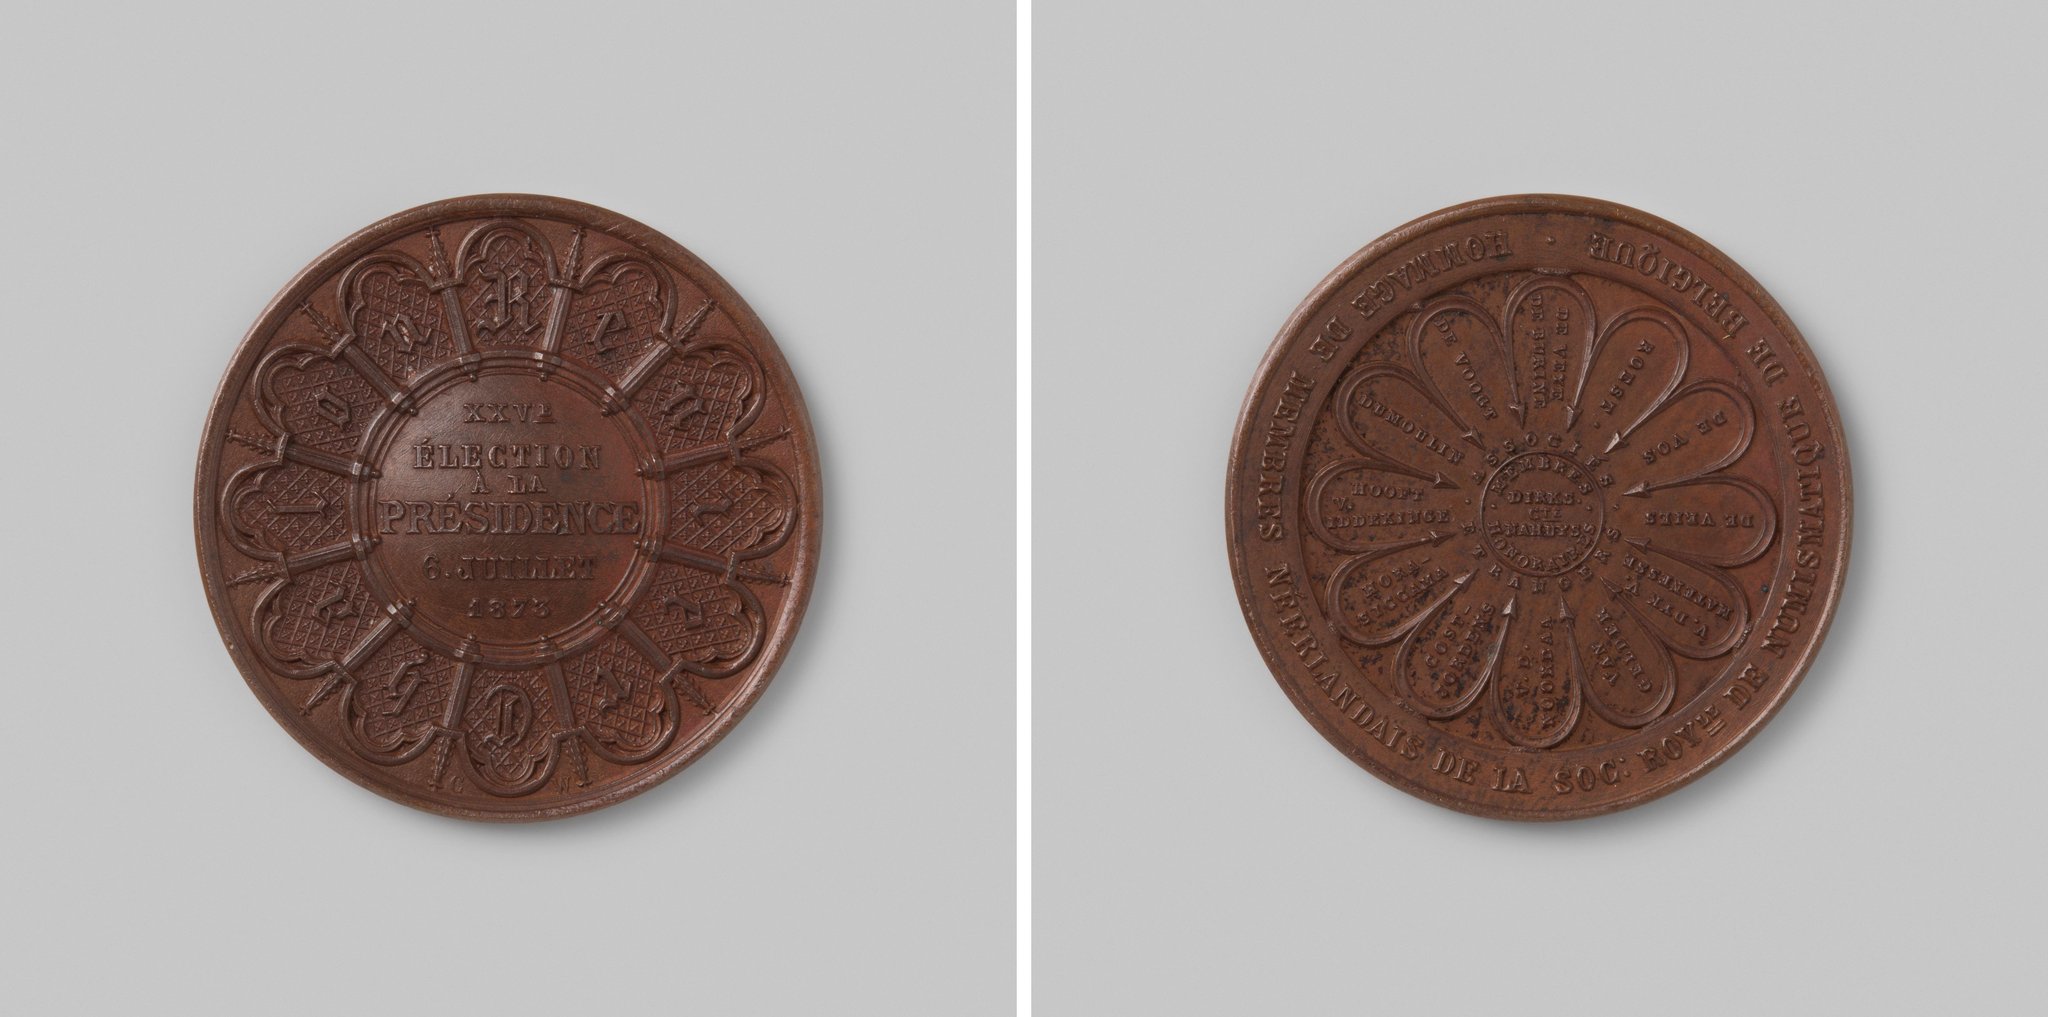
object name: honorary medal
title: Renier Chalon, voor de vijfentwintigste maal tot voorzitter van de Societe Royale de Numismatique de Belgique gekozen, penning aangeboden door de Nederlandse leden van de vereniging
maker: karel wiener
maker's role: medailleur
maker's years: 1831-1888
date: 1873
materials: bronze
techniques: striking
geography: brussels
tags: bergen (belgië), numismaat, fotograaf, verzamelaar, renier chalon, société royale de numismatique de belgique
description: Bronzen penning. Voorzijde: opschrift in medaillon binnen in bogen verdeelde rand: in iedere boog een letter in Gothisch schrift van naam van Renier Chalon. Keerzijde: bloemvormig ornament, opgevuld met namen van leden van vereniging binnen omschrift